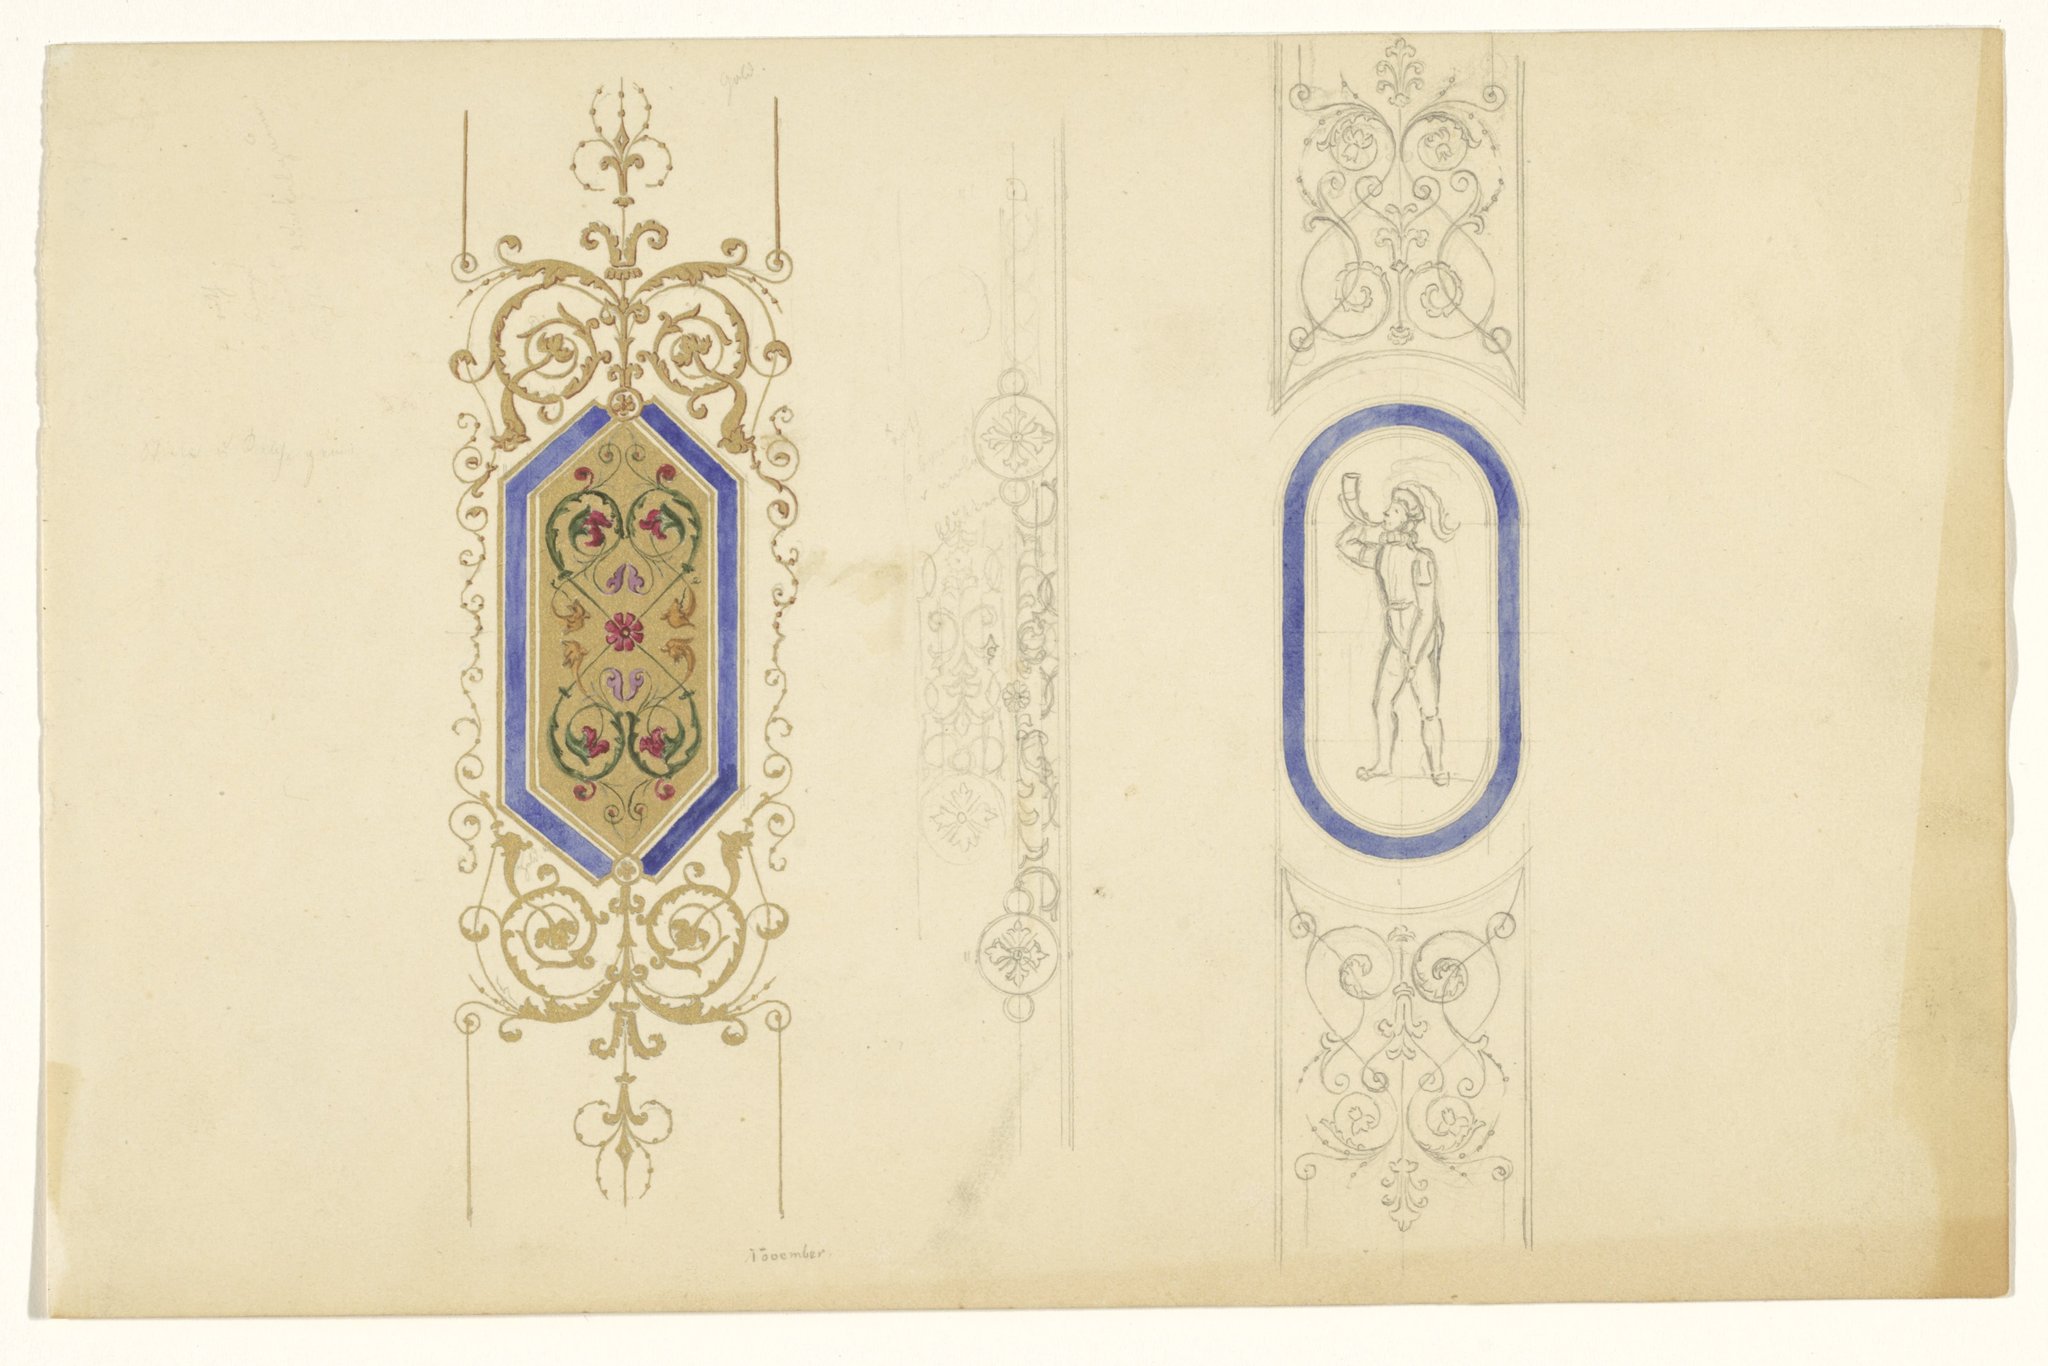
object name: drawing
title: Drie centrale motieven van pilastervullingen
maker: franz jakob kreuter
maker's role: architect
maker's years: 1813-1889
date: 1835-1860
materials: paint, paper, pencil, watercolor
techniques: brush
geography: vienna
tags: ornaments ~ art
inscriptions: inscription: ‘November.’, watermark: ‘BLA[…].’